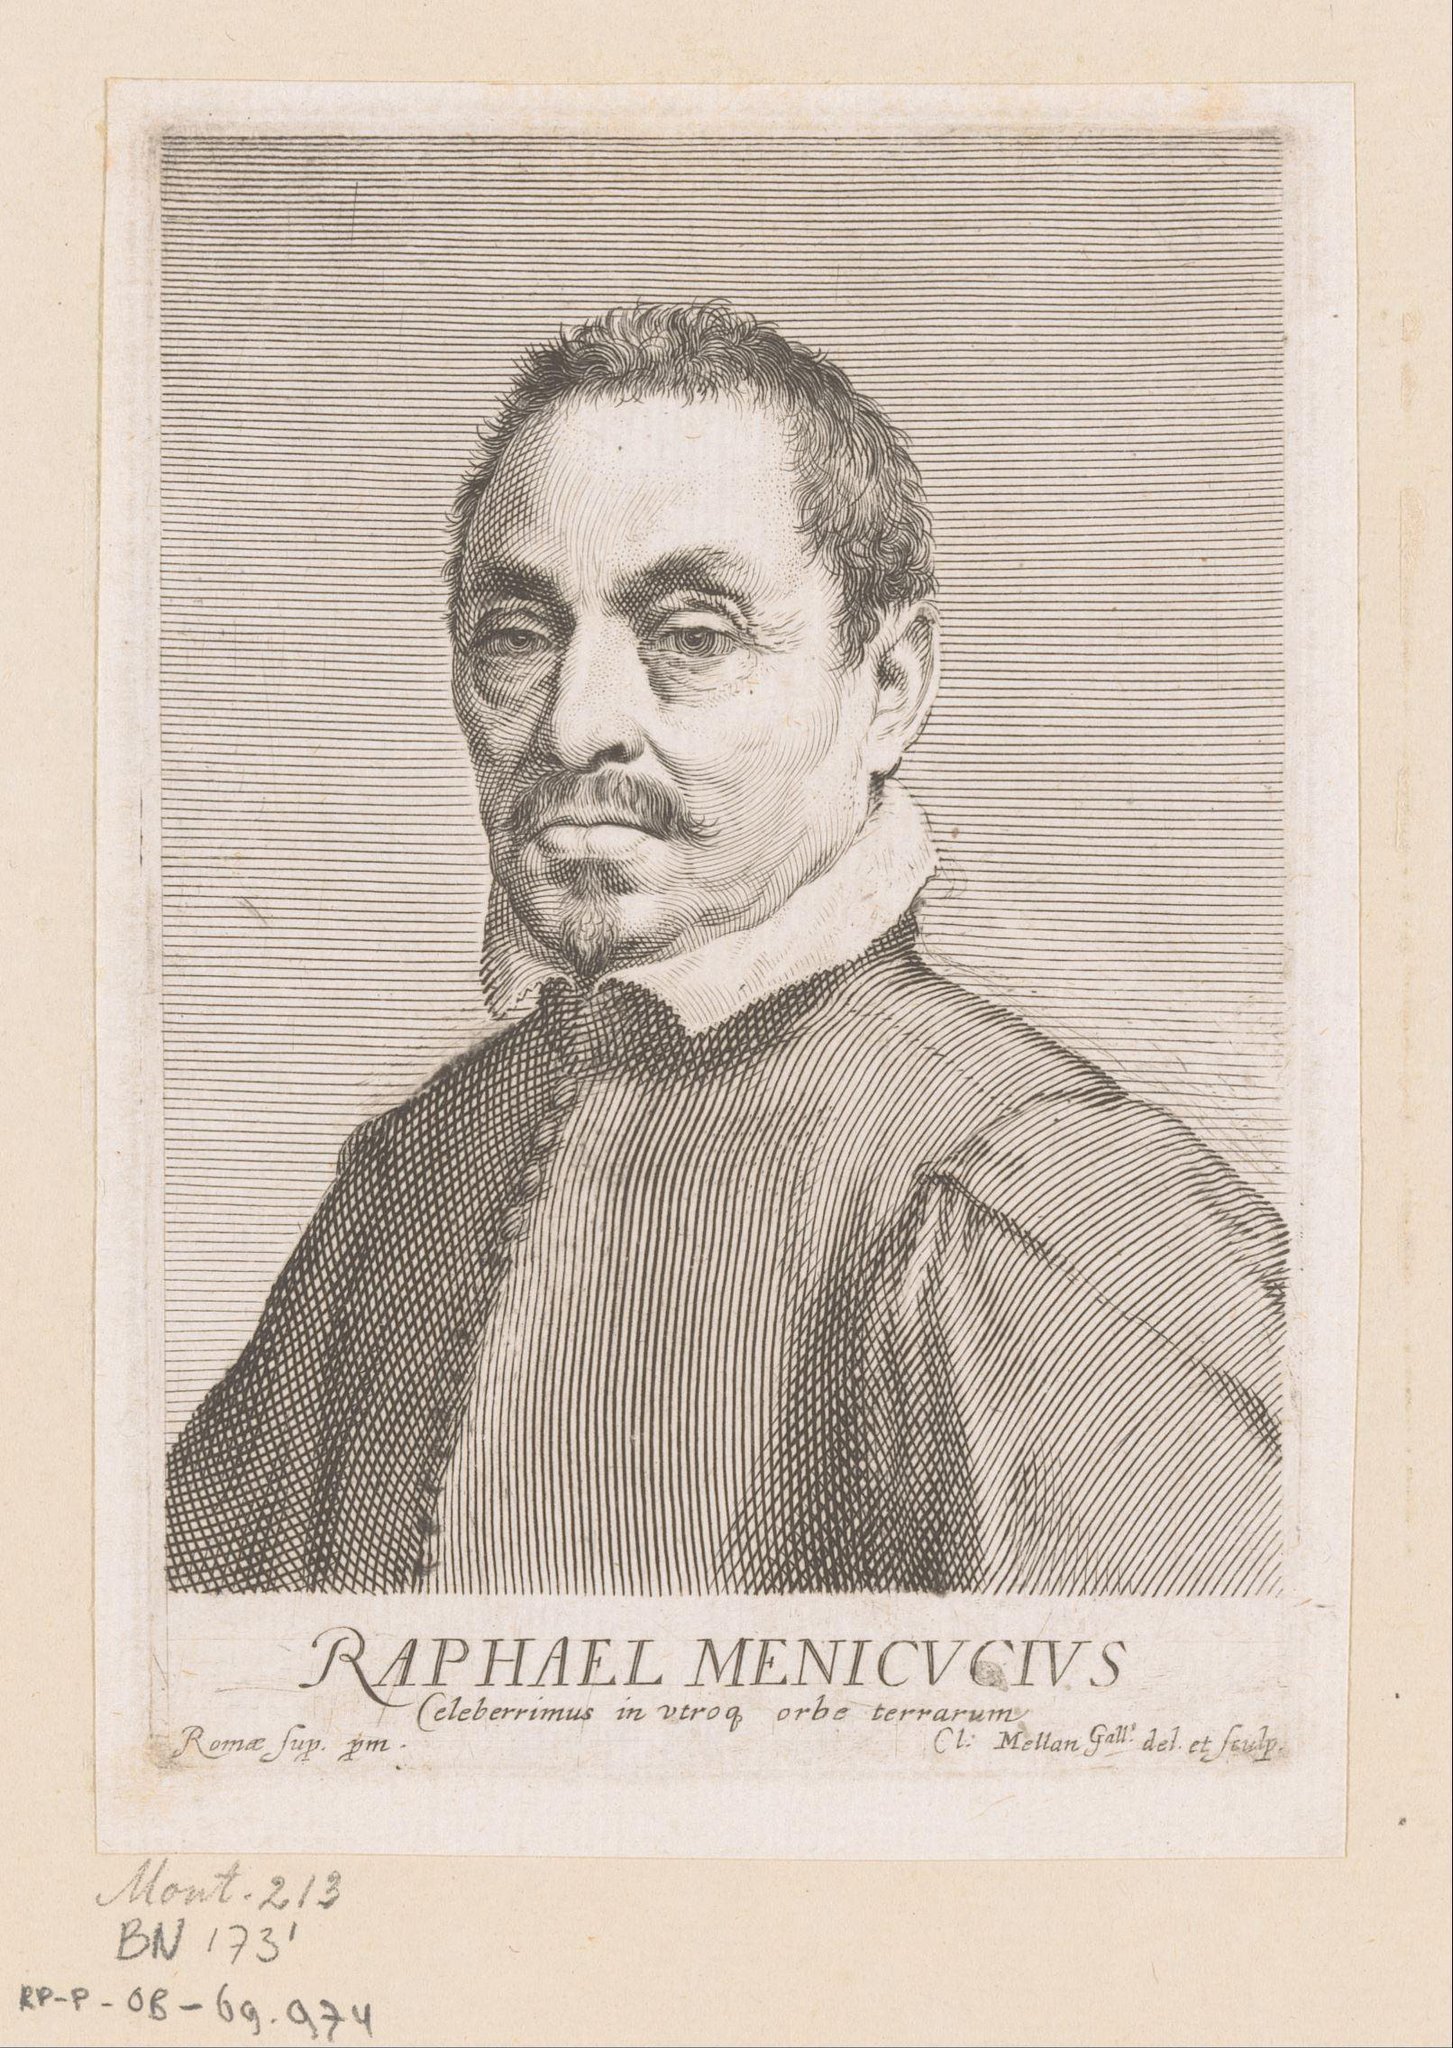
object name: print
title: Portret van Raffaello Menicucci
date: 1624-1636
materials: paper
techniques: engraving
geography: rome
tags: historical persons, portrait of a musician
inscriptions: collector's mark: Lugt 240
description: De plaat bevindt zich in het Musée du Département des Estampes.